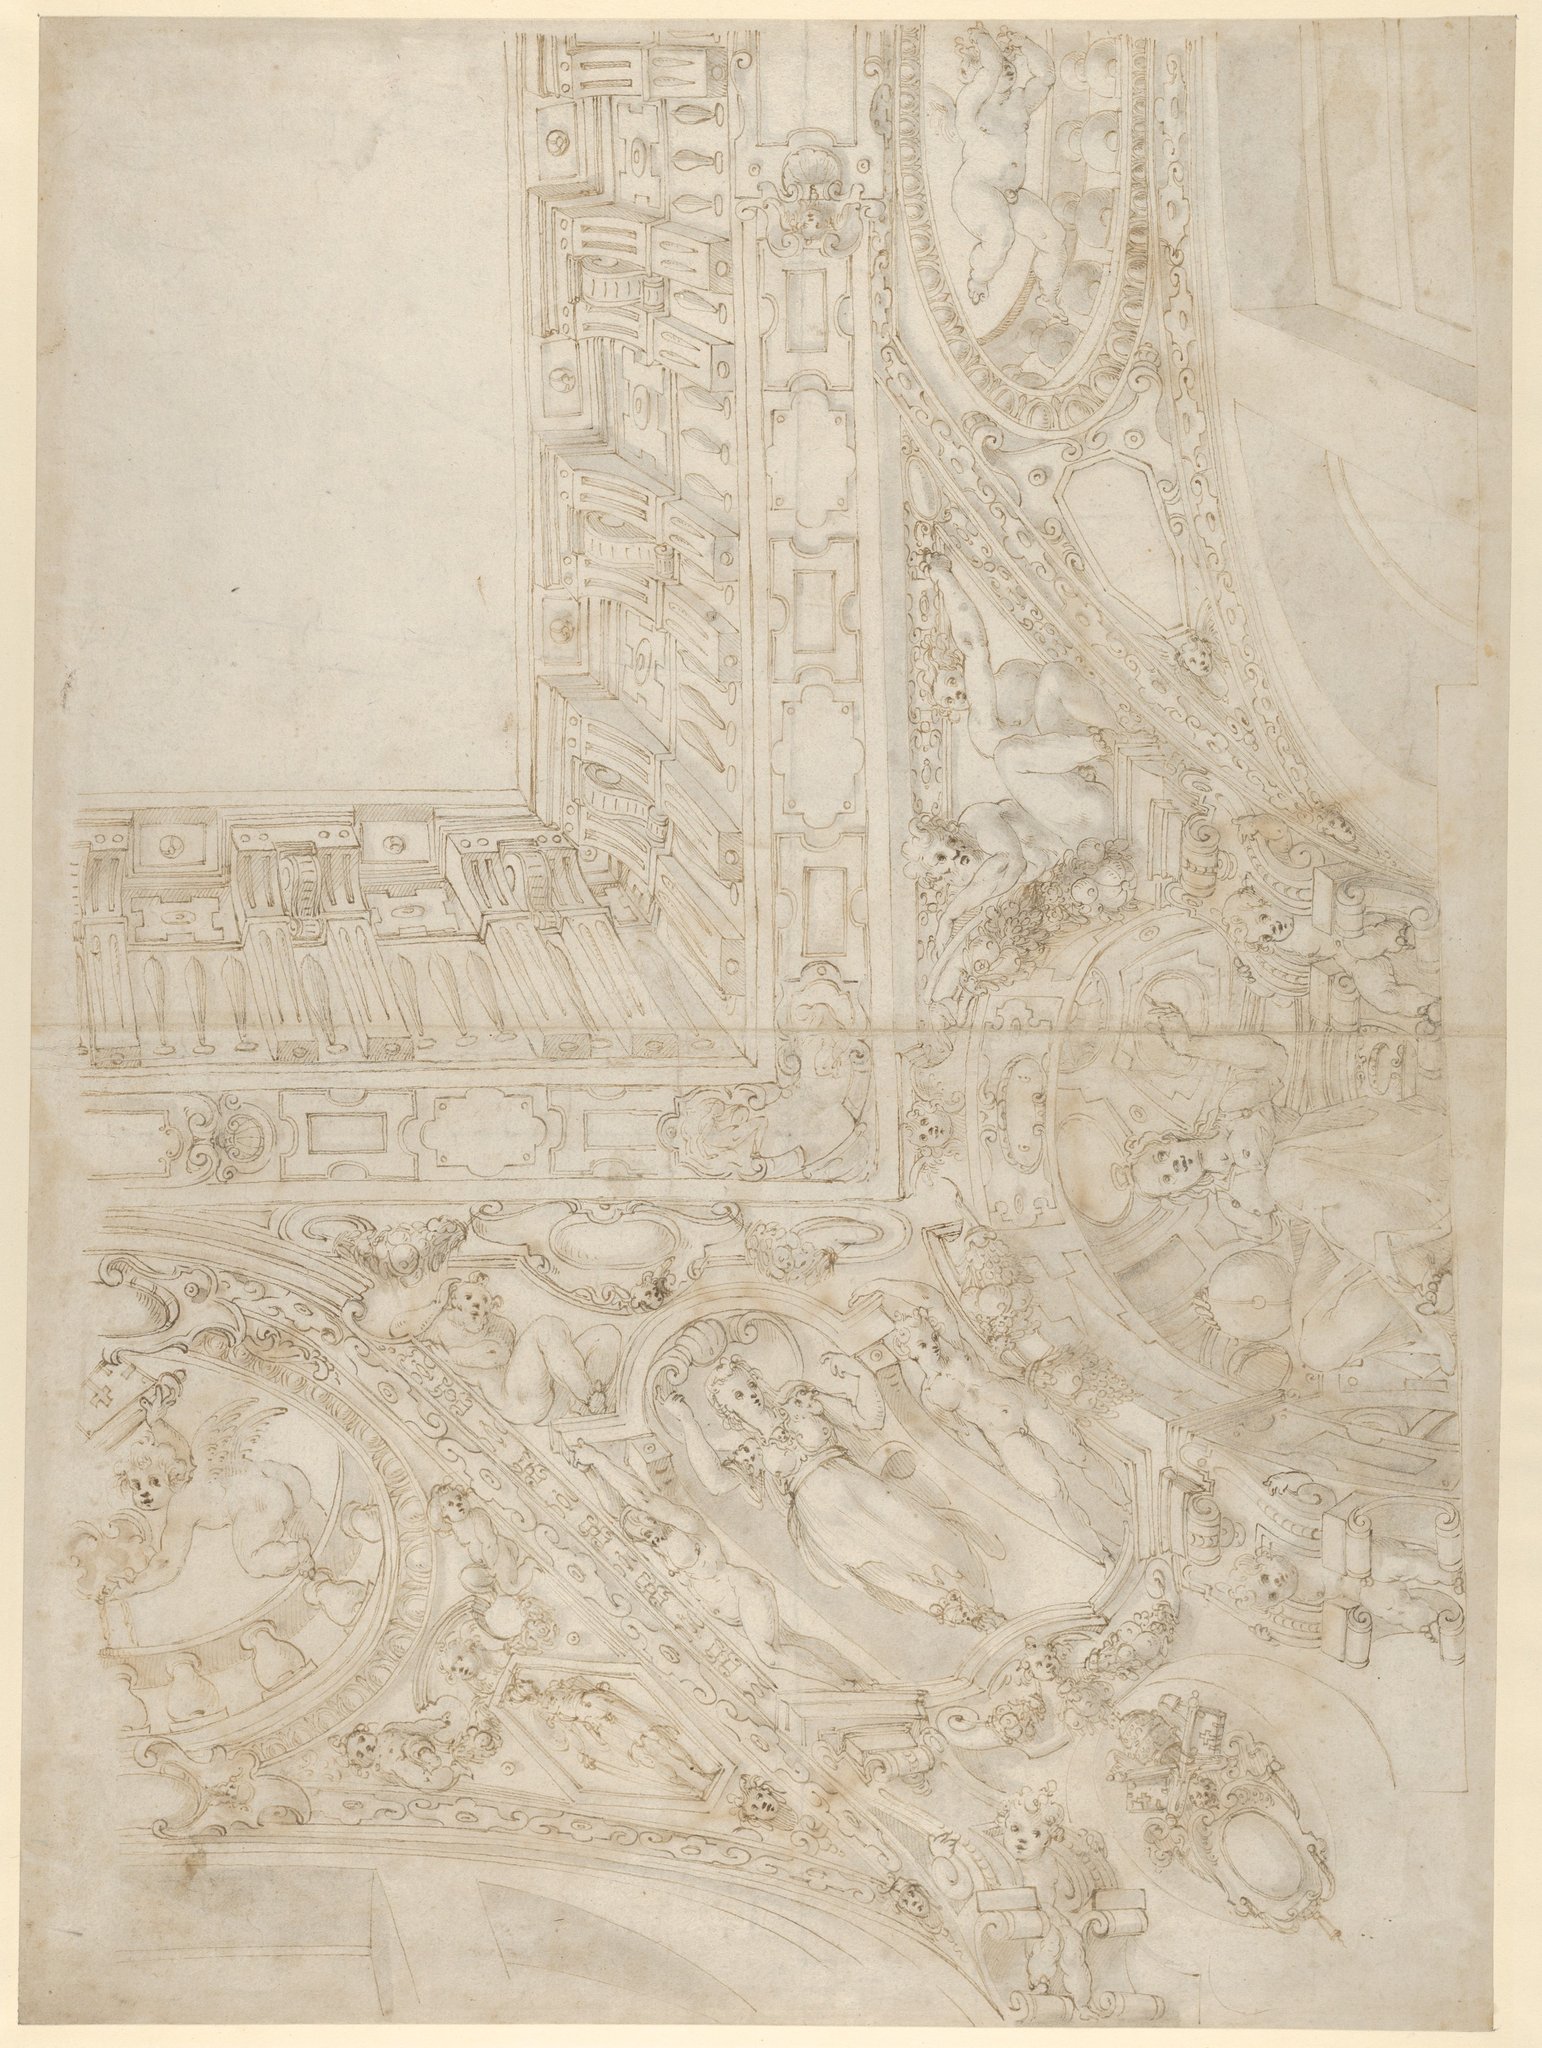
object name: drawing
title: Project for a Rectangular Ceiling with Papal Coat of Arms (recto); Design for a Courtyard (verso)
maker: giovanni alberti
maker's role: artist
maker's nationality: italian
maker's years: 1558-1601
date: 1558-1601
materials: chalk, ink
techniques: brush, pen, wash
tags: human figures,courtyards,coat of arms